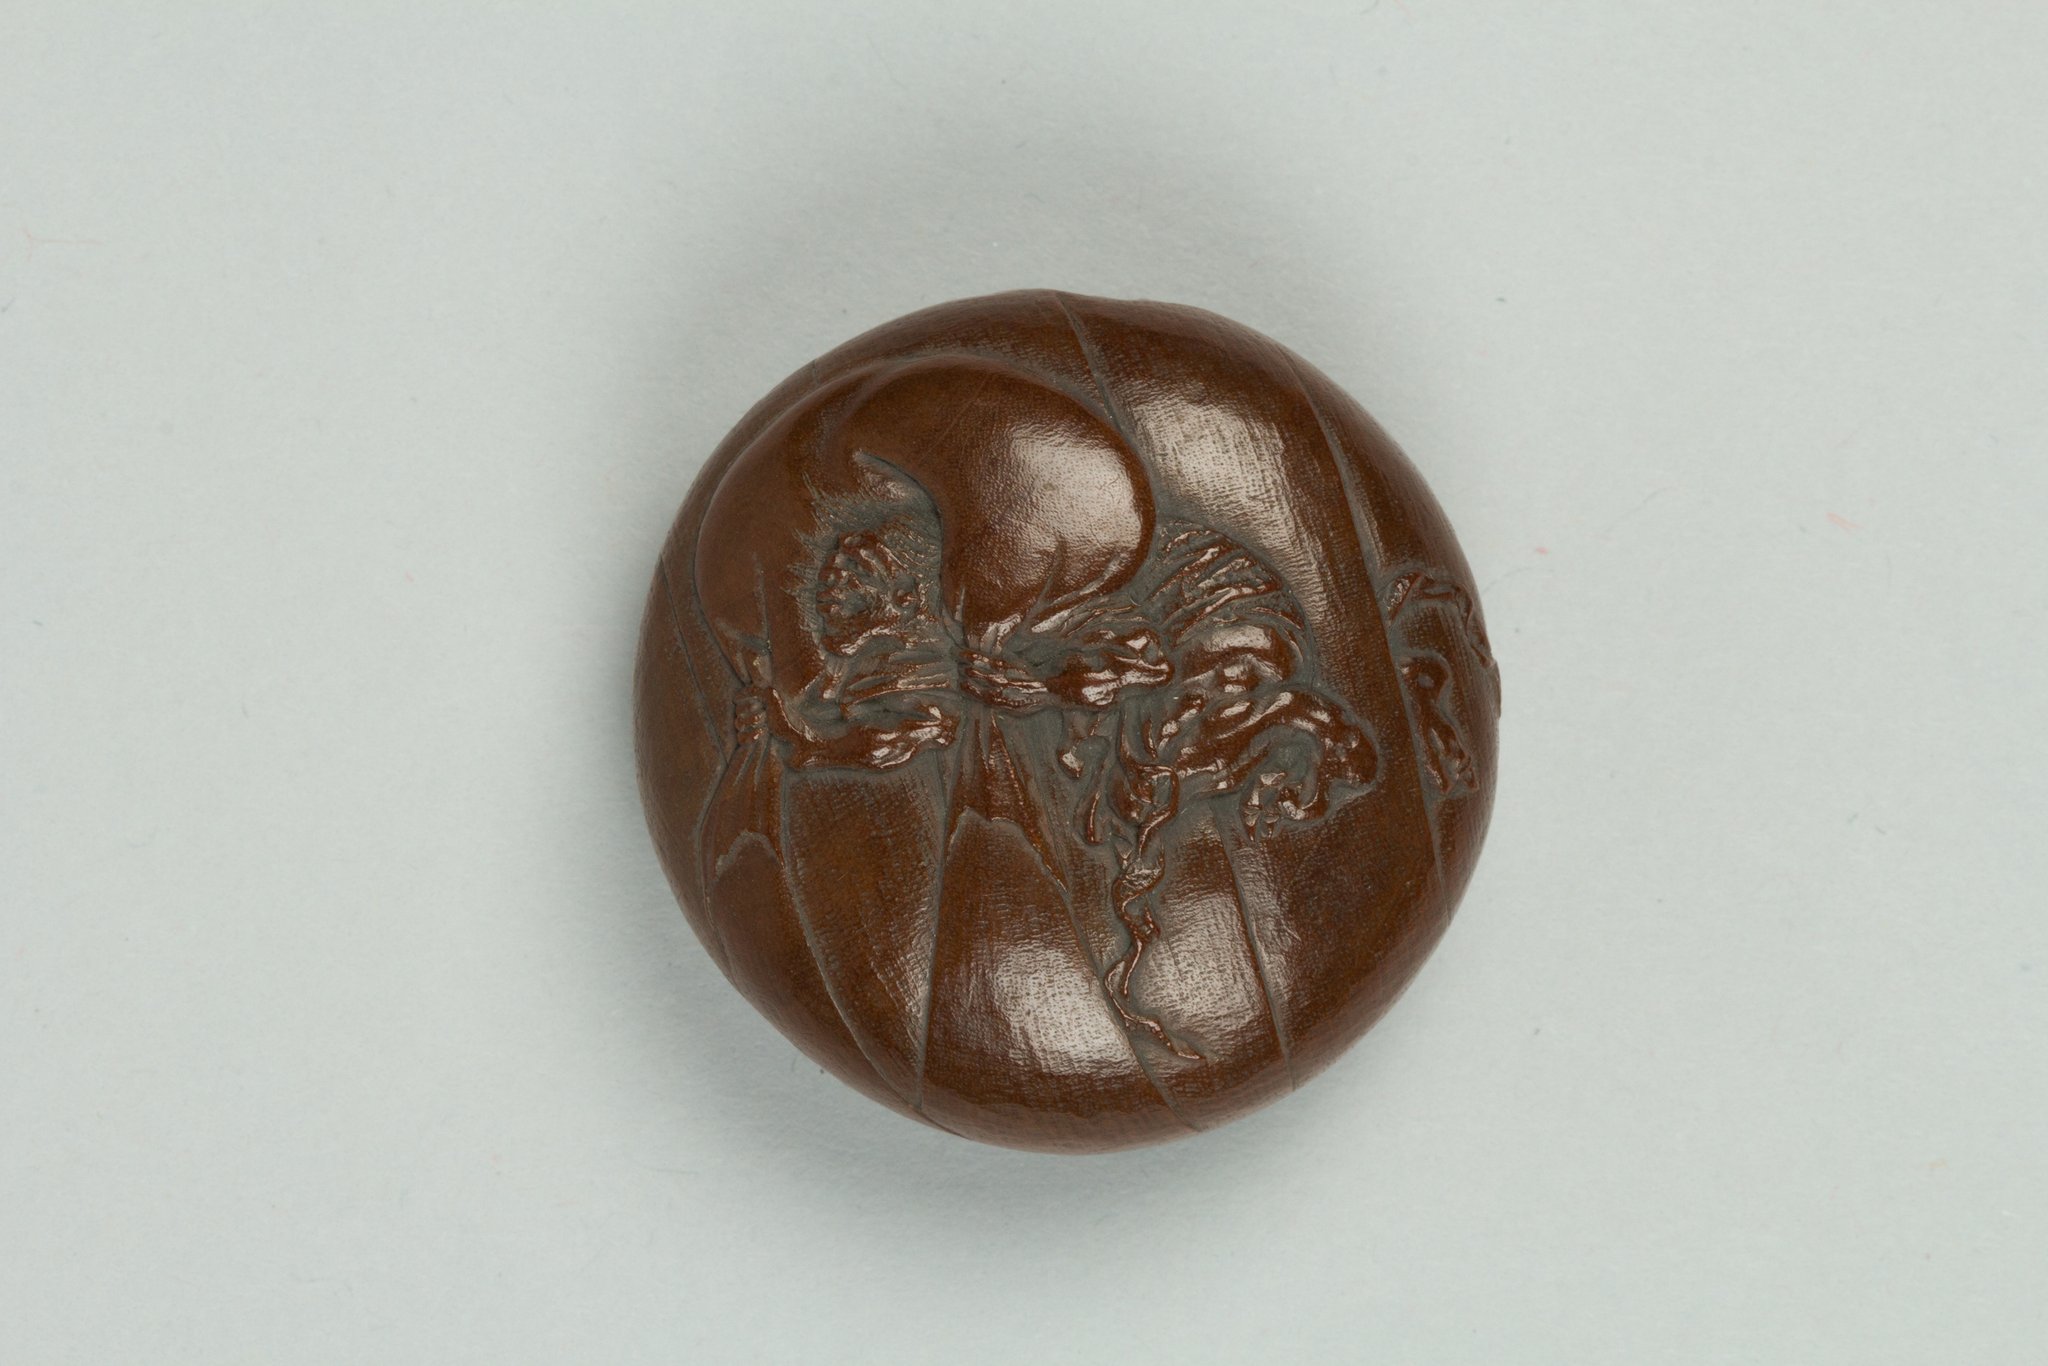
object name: netsuke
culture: japanese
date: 1601-1700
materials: wood